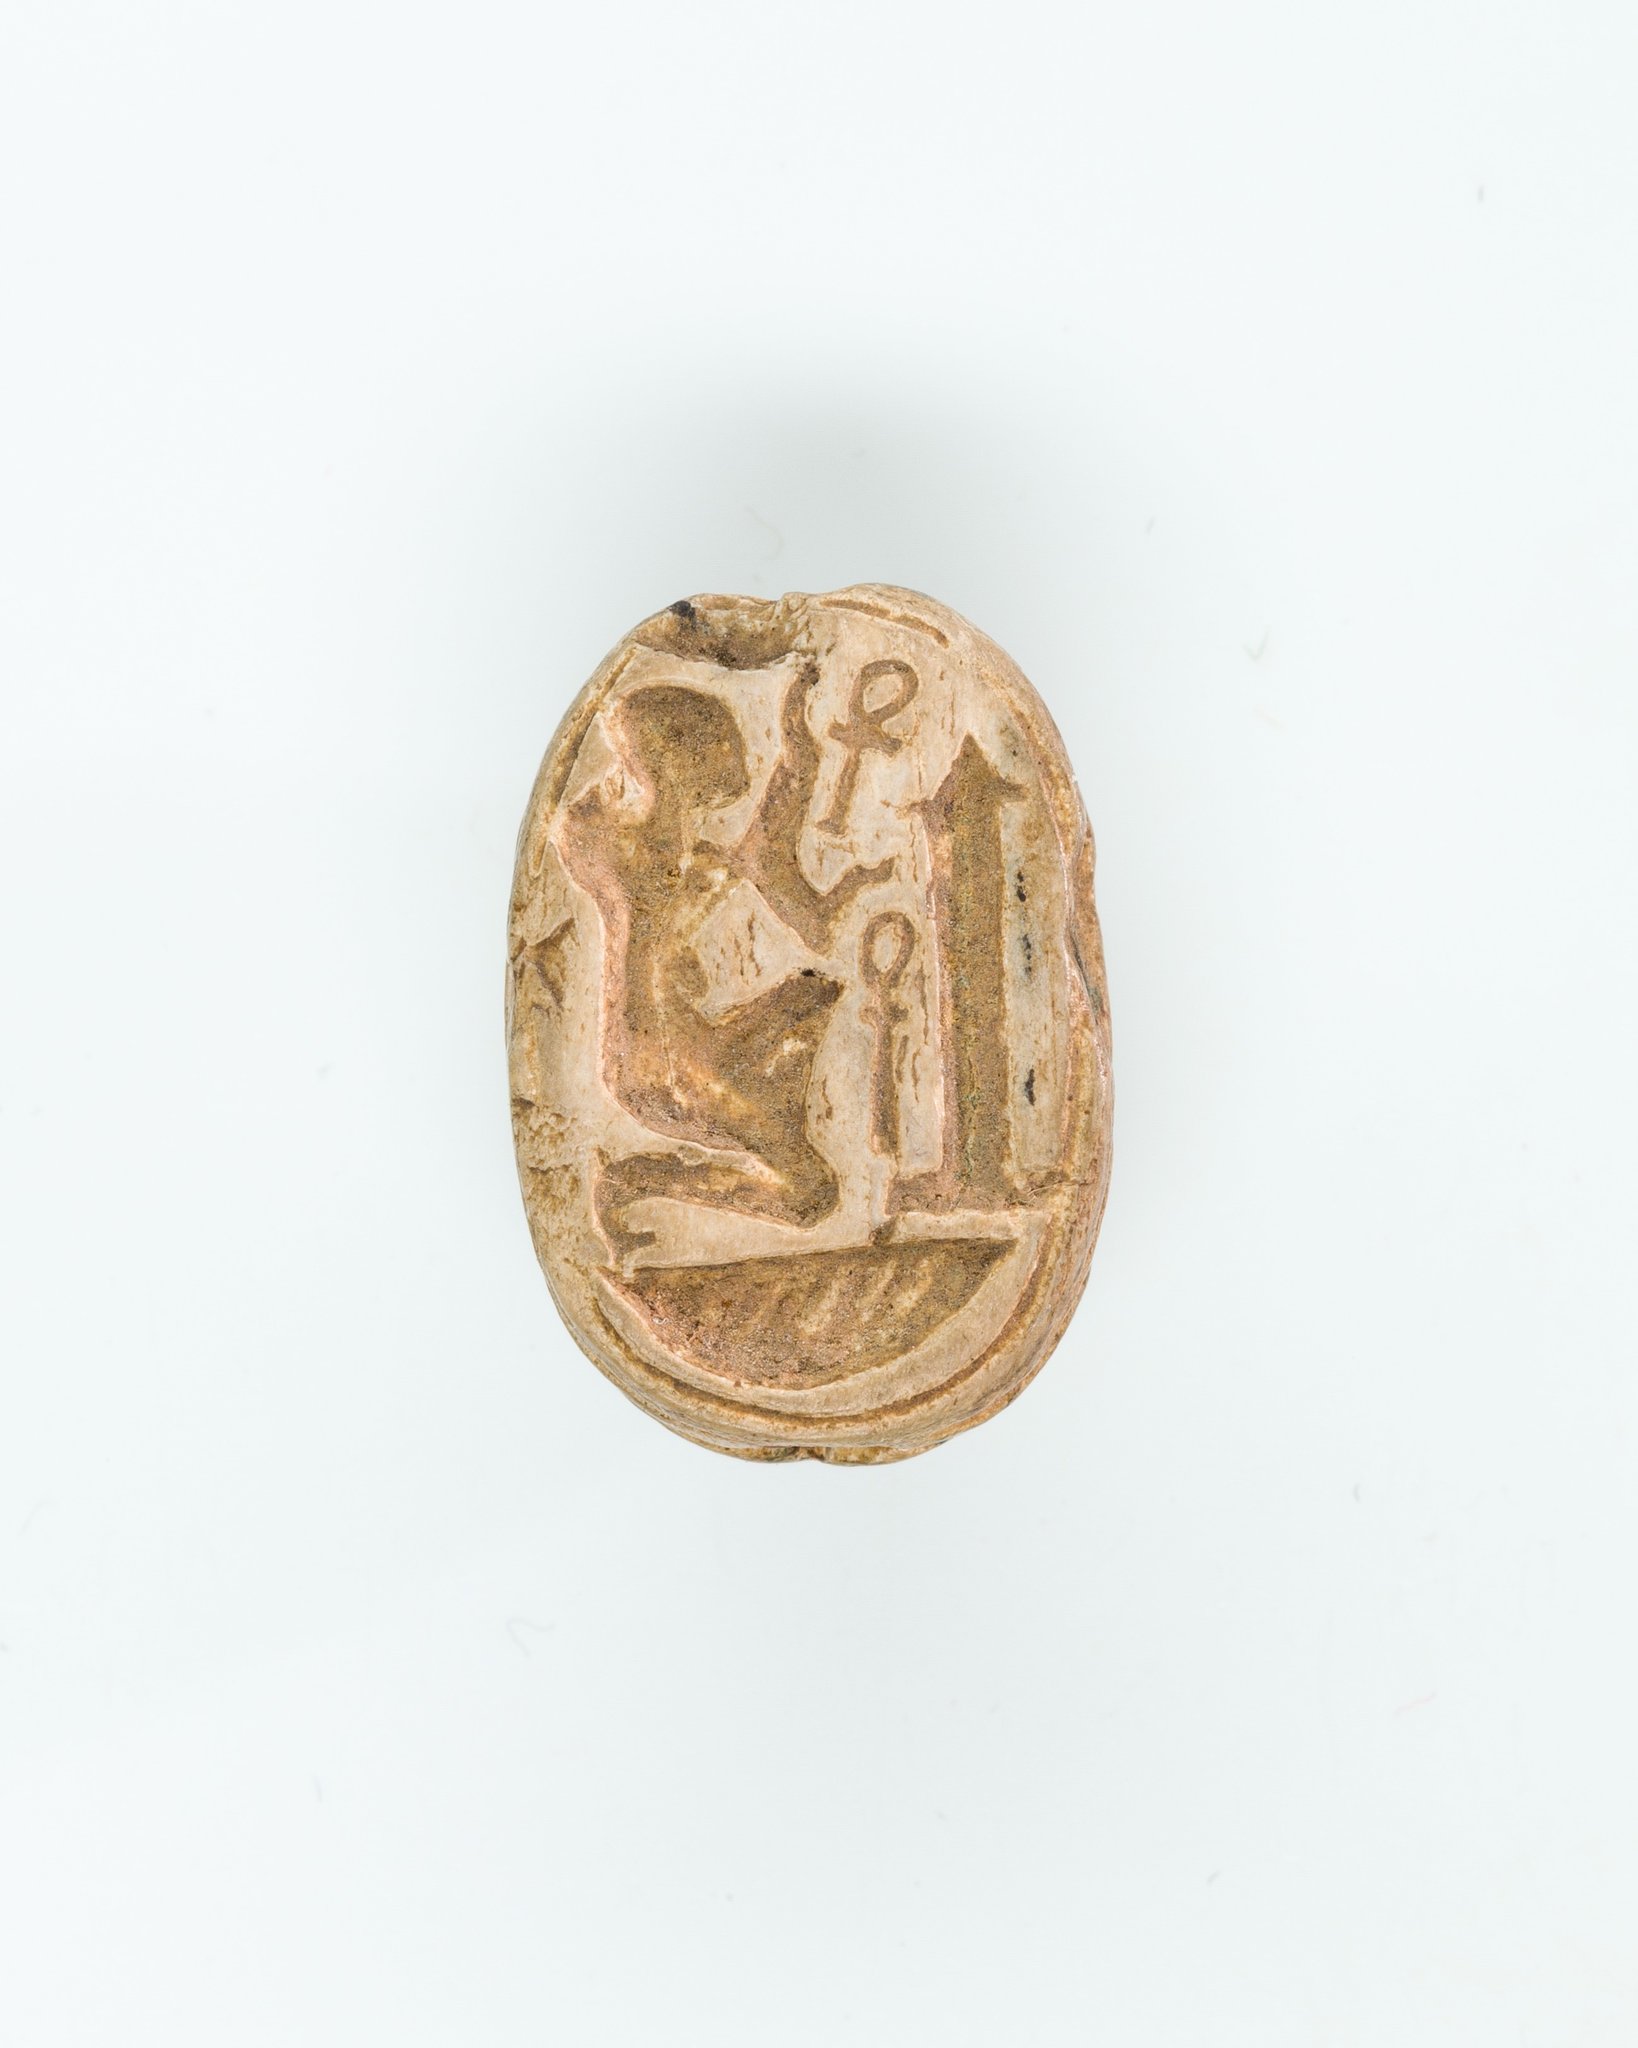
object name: scarab, obelisk, kneeling figure, ankh, nb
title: Scarab with a Kneeling Figure Before an Obelisk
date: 1070-664 BCE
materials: stone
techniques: glazing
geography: egypt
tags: human figures,scarabs